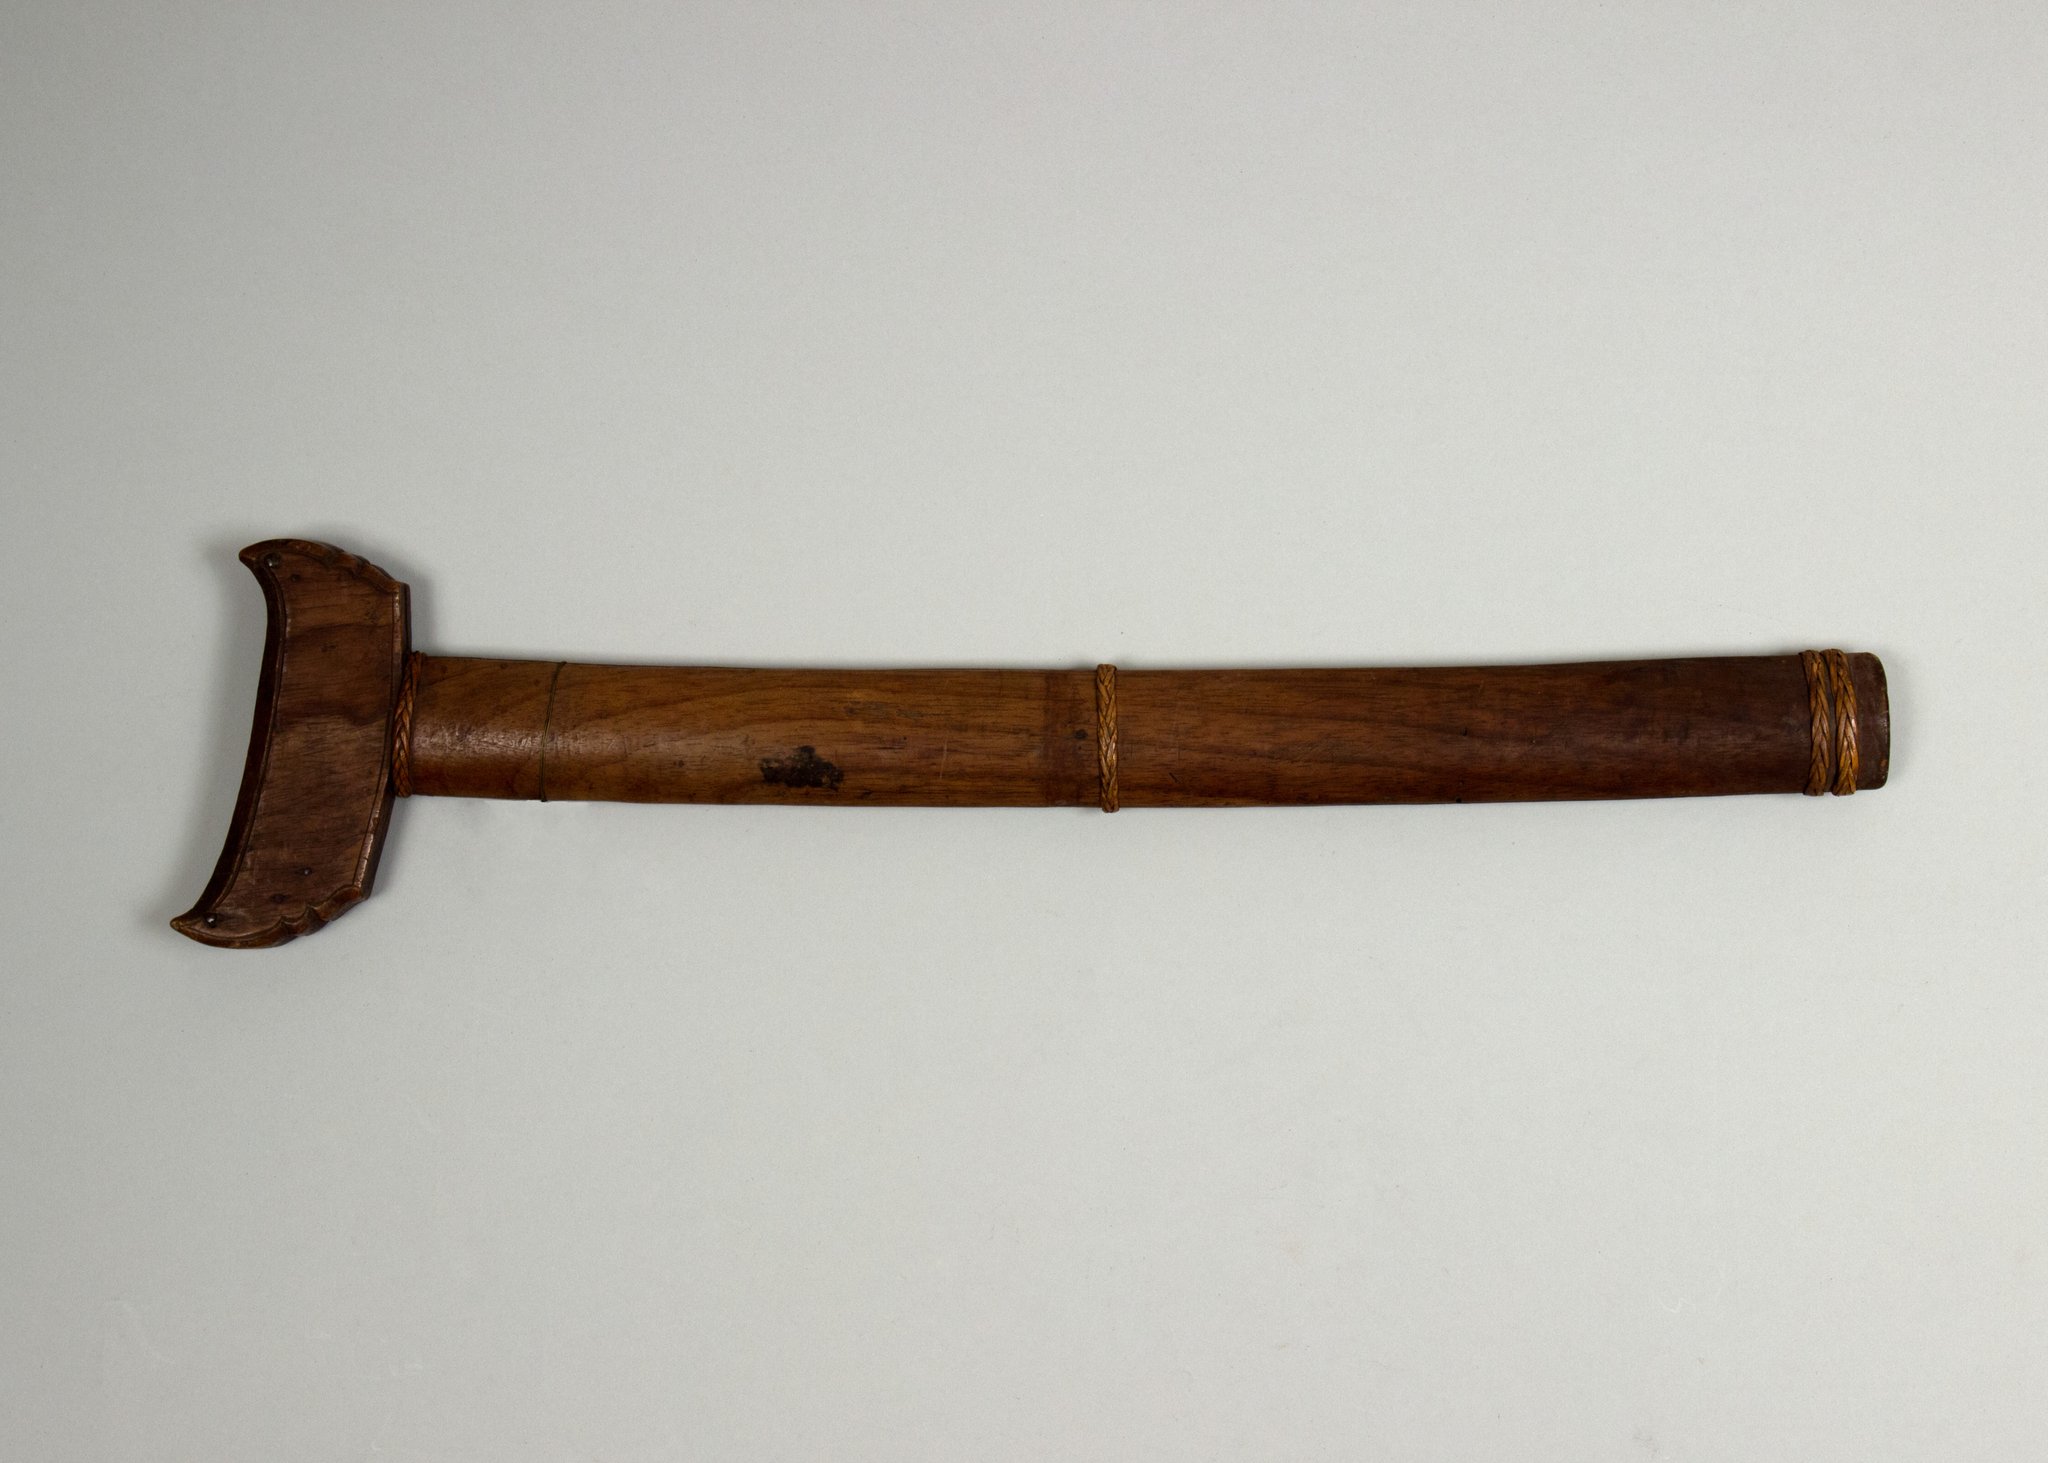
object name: kris with sheath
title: Sheath for a Kris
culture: philippine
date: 1701-1900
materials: cord, wood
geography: philippines